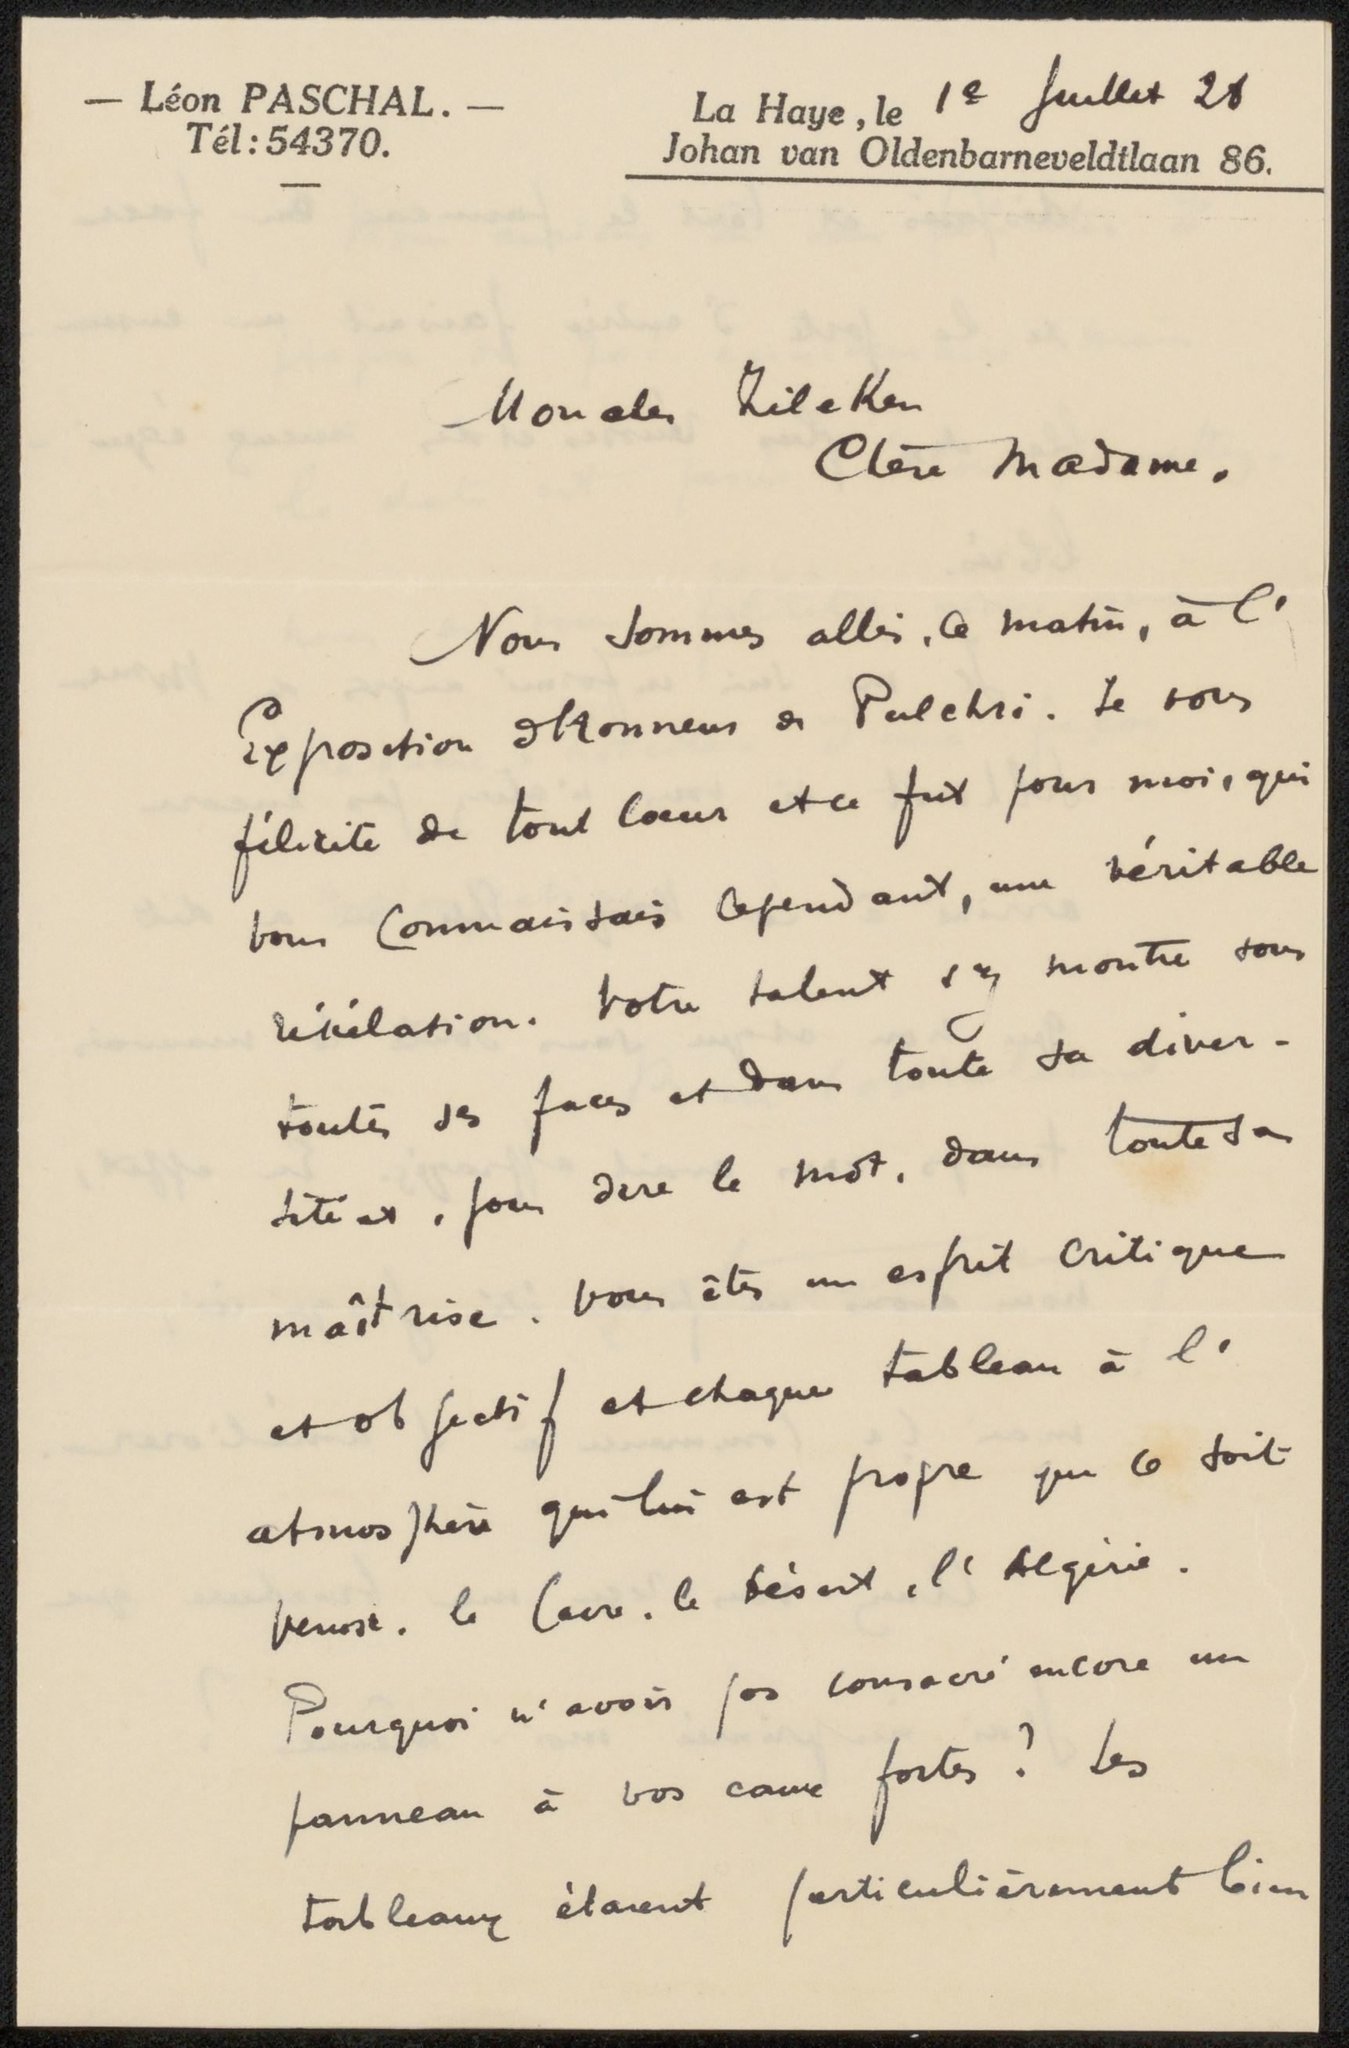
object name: letter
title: Brief aan Philip Zilcken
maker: léon paschal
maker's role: schrijver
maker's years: 1873-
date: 1928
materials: ink, paper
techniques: pen, printing, writing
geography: the hague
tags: the hague, painter, draughtsman, philip zilcken, the graphic arts, painting (including book-illumination, miniature-painting), exhibition ~ art, printed matter, venice